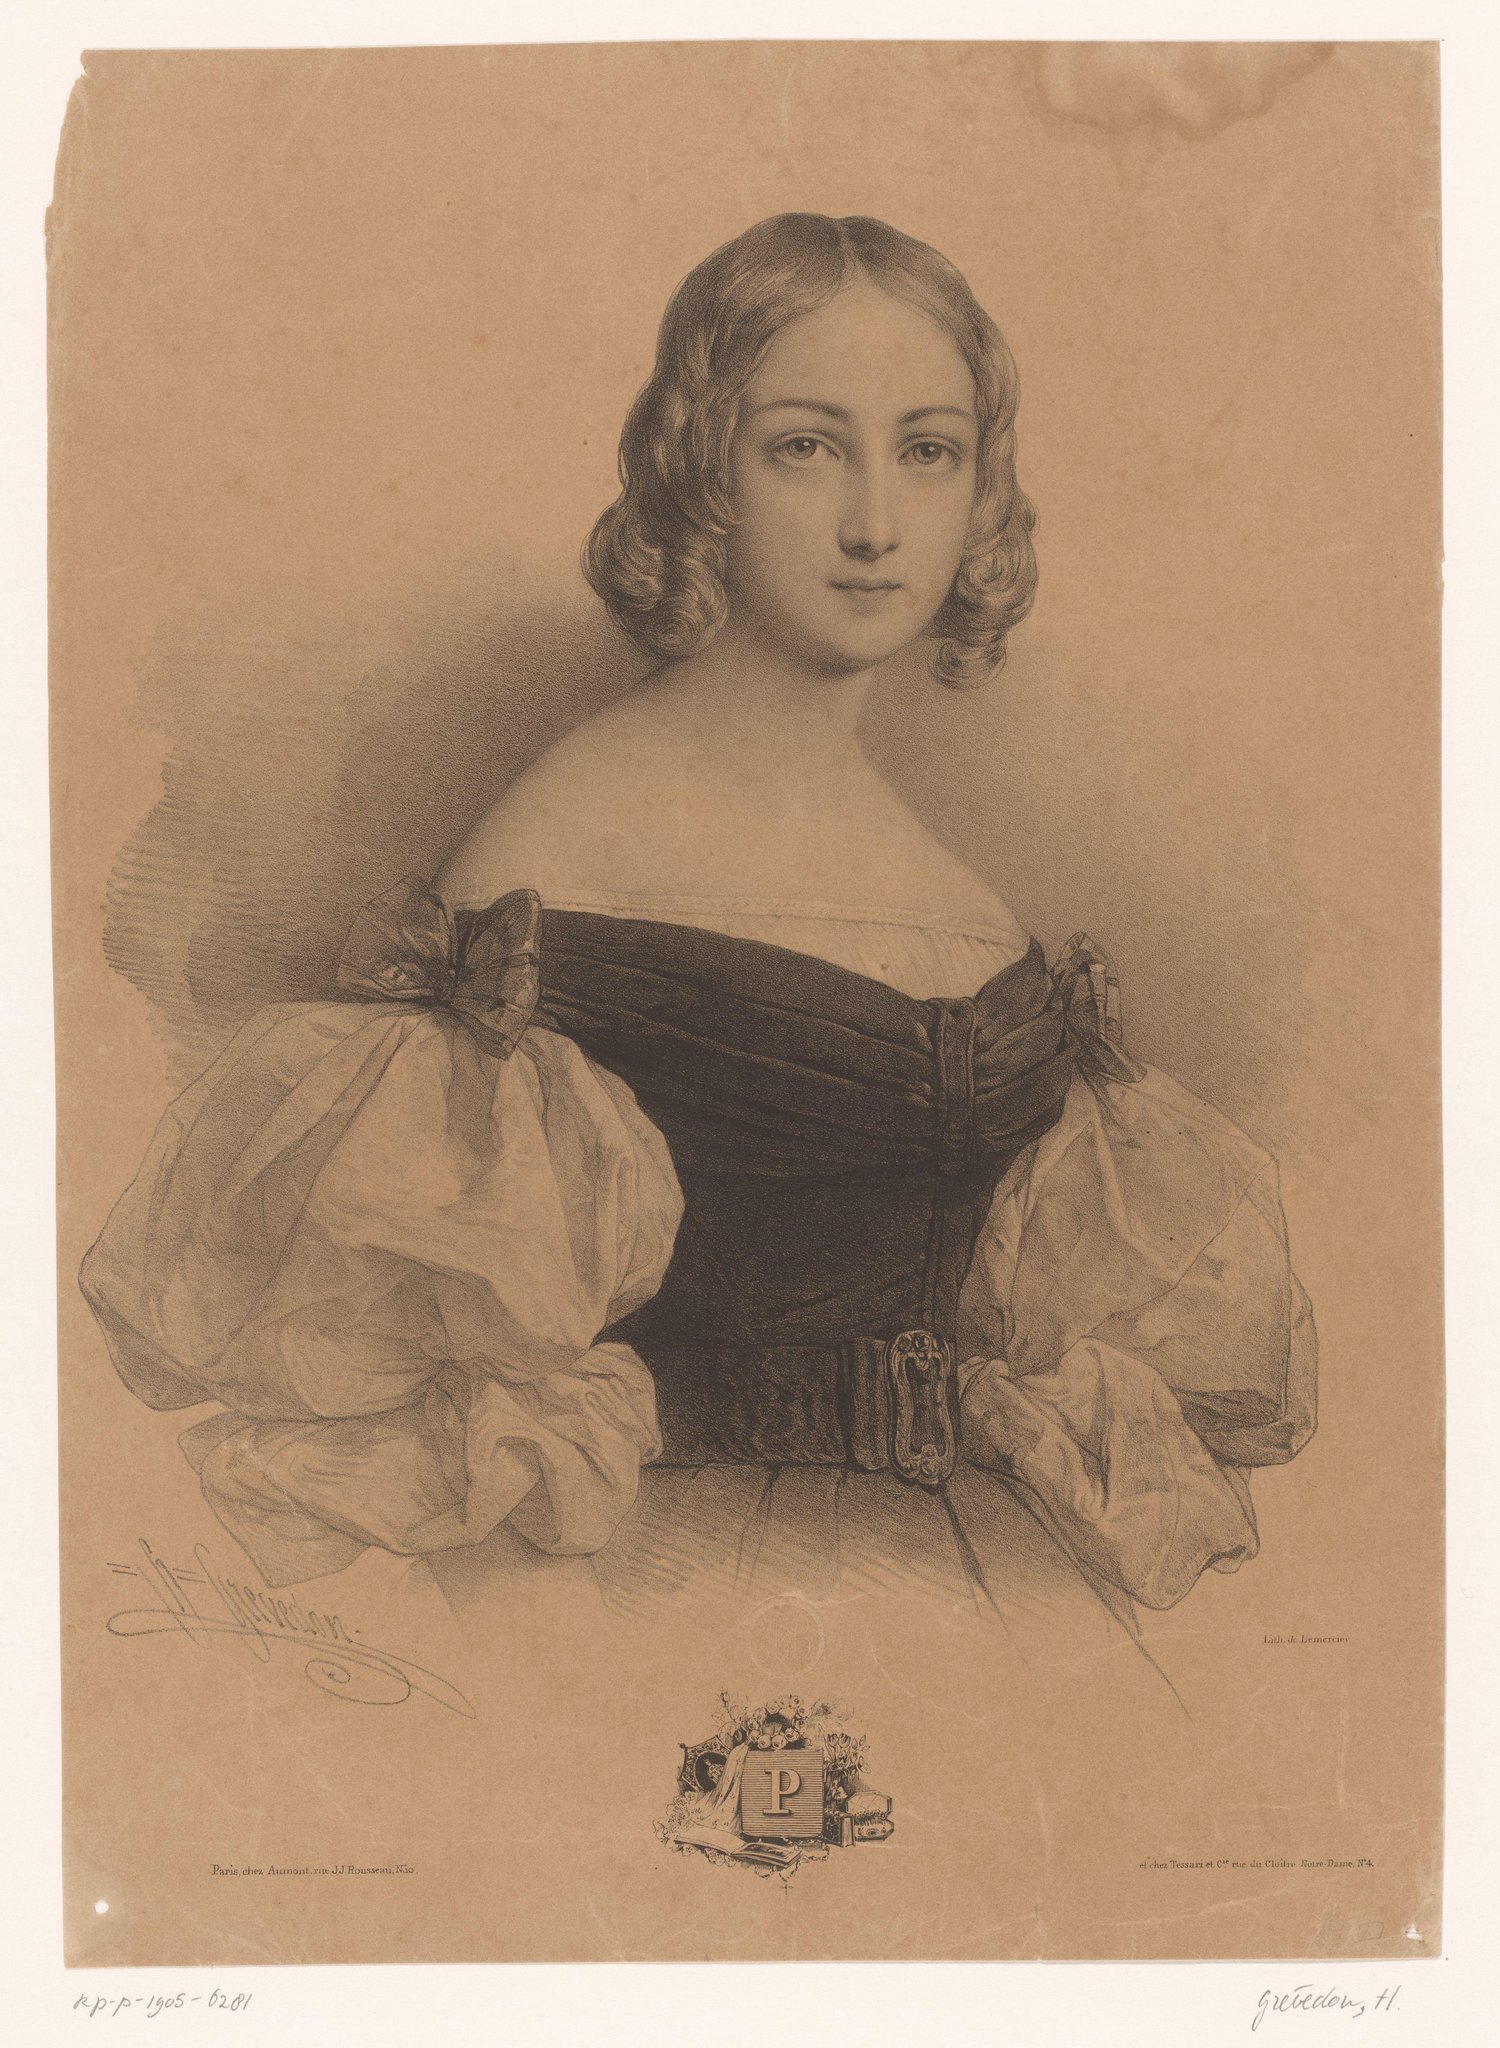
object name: print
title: Dames voor elke letter van het alfabet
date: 1834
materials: paper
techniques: lithograph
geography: paris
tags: adolescent, young woman, maiden, letters, alphabet, script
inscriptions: check stamp: Lugt 88b, collector's mark: Lugt 2228a